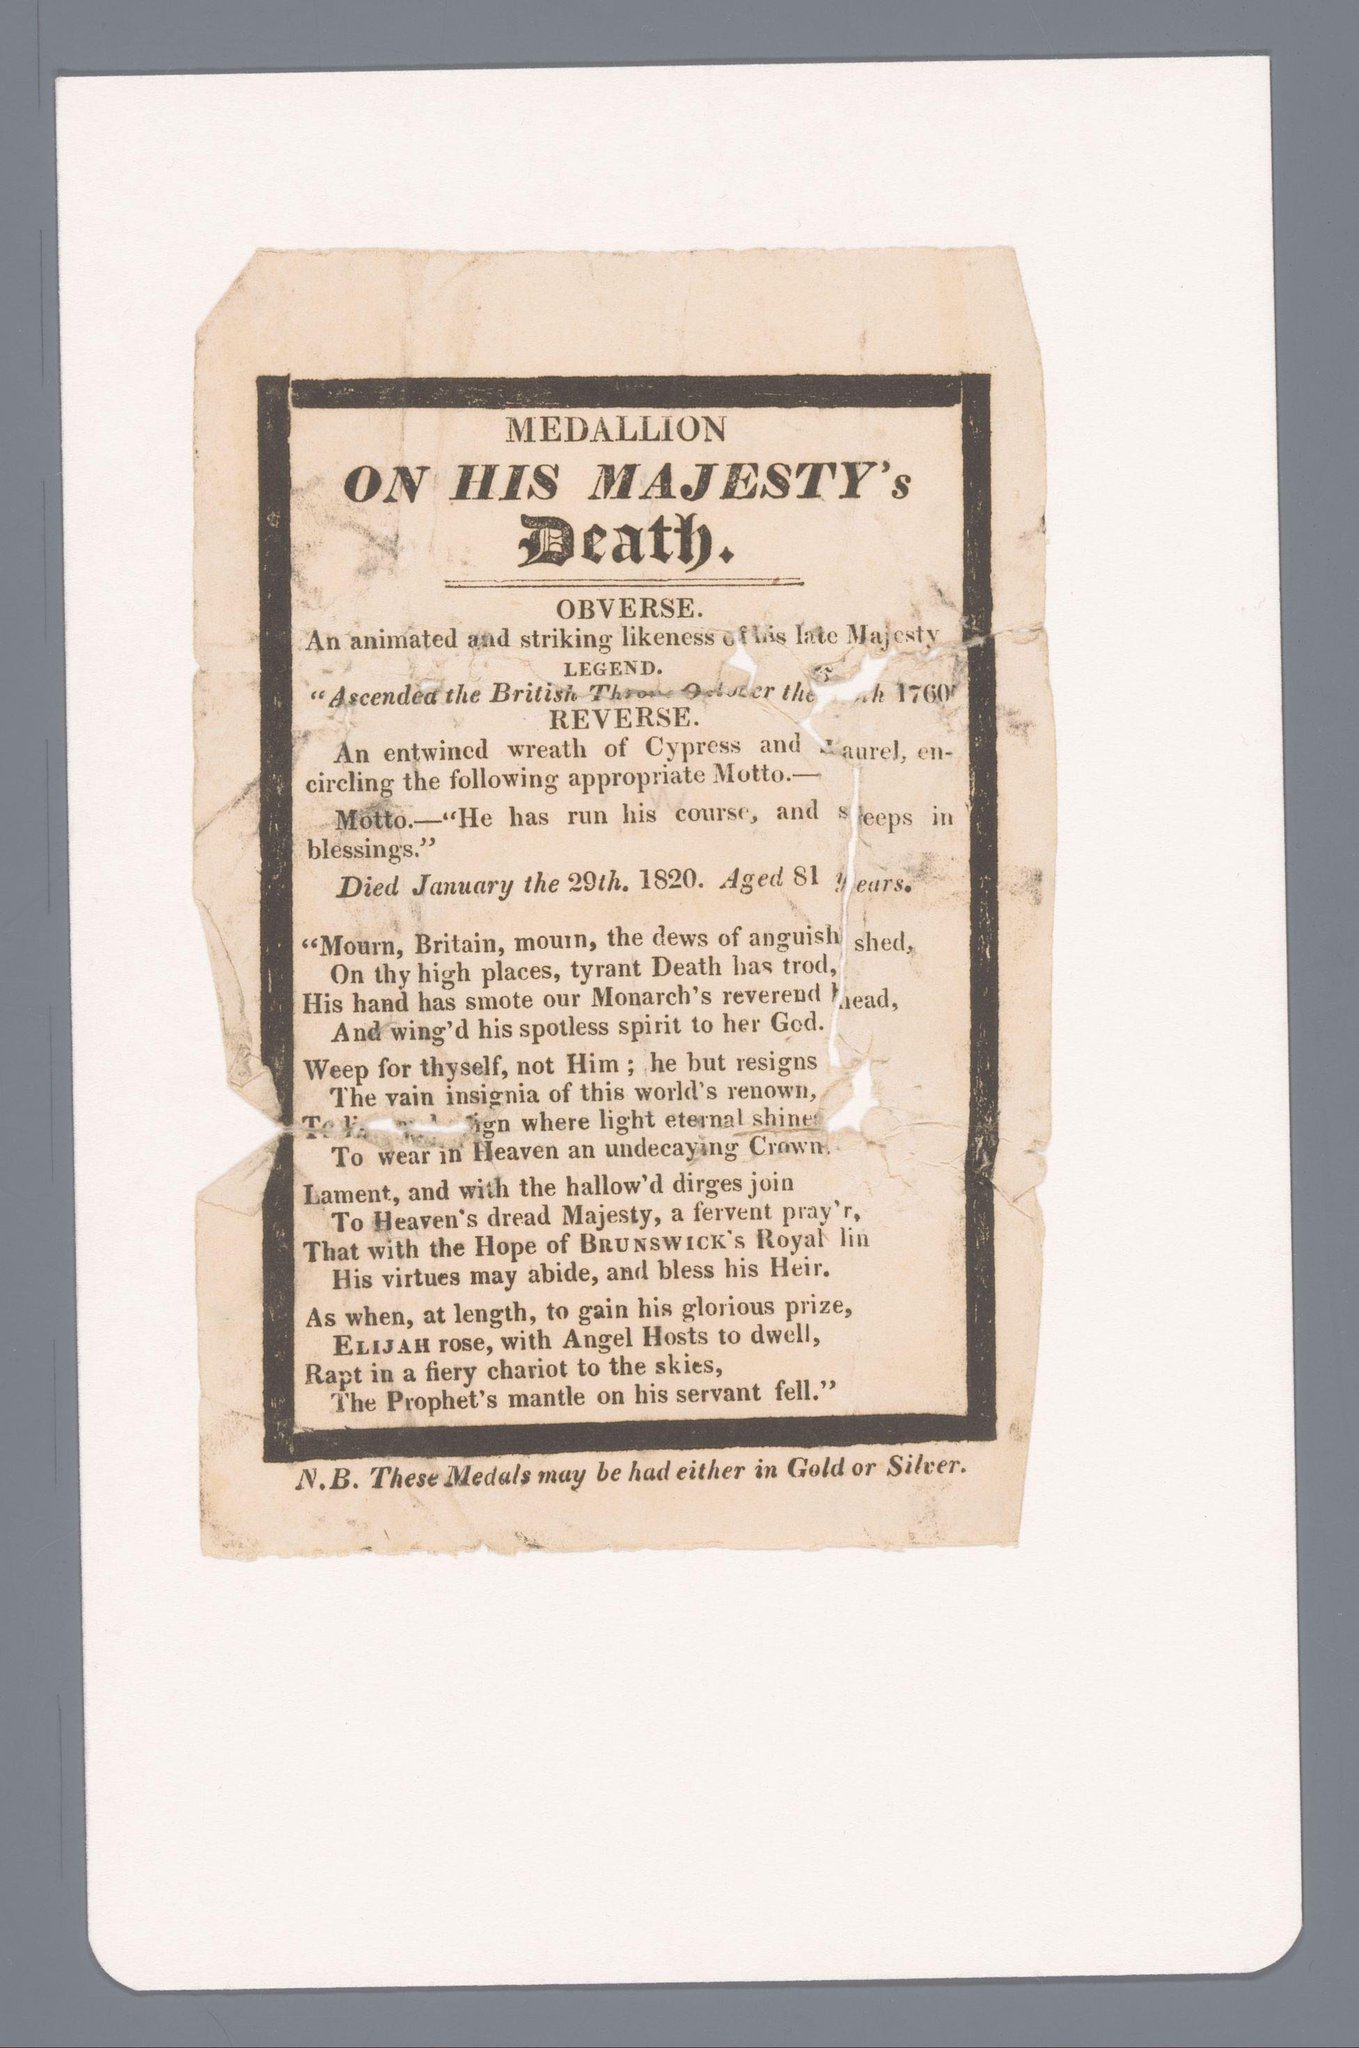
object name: penningverklaring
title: Medallion on his Majesty's Death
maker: Anonymous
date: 1820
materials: paper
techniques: letterpress printing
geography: england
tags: george iii (koning van het verenigd koninkrijk)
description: Eenzijdig, rechthoekig stuk papier bedrukt met opschrift in zwarte omlijsting.